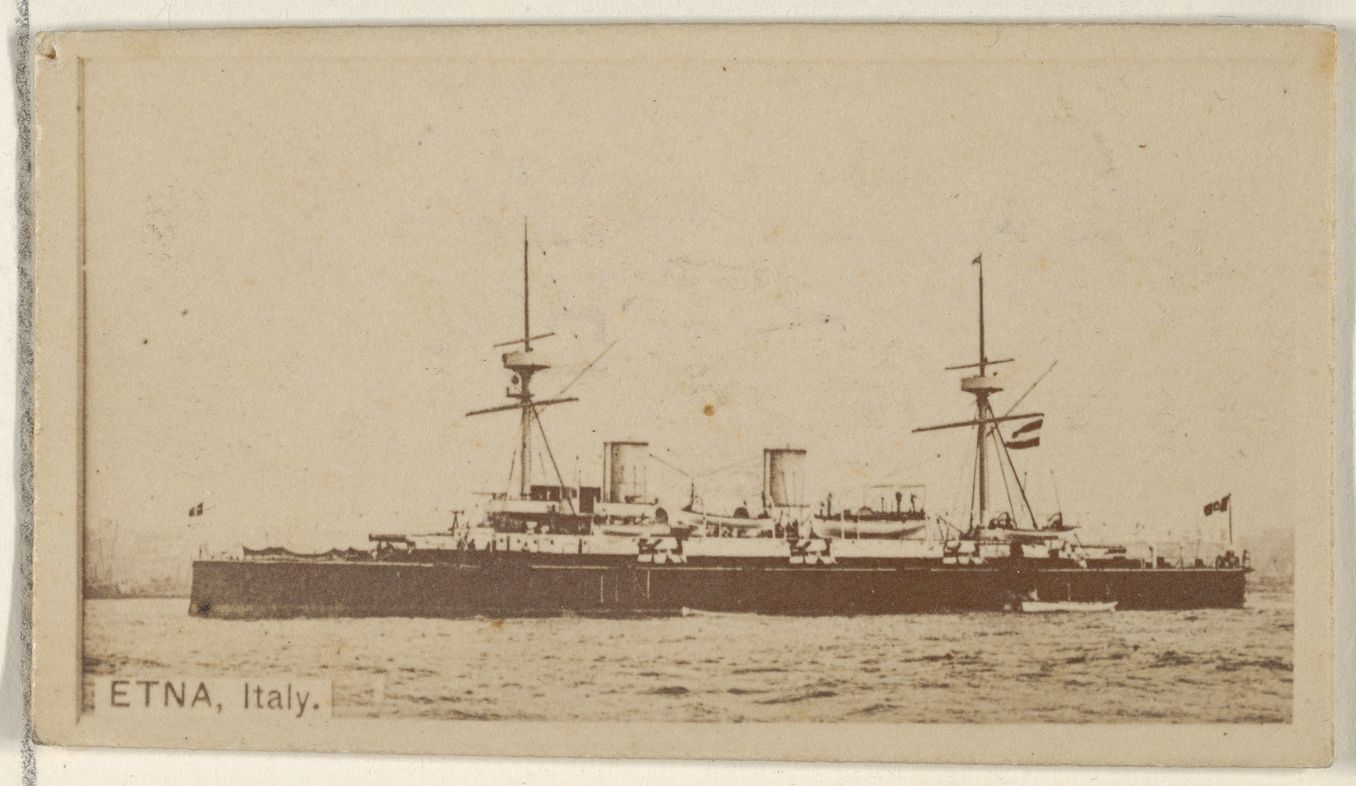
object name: photograph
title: Etna, Italy, from the Famous Ships series (N50) for Virginia Brights Cigarettes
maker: allen & ginter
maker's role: publisher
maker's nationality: american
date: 1895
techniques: albumen silver print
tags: ships